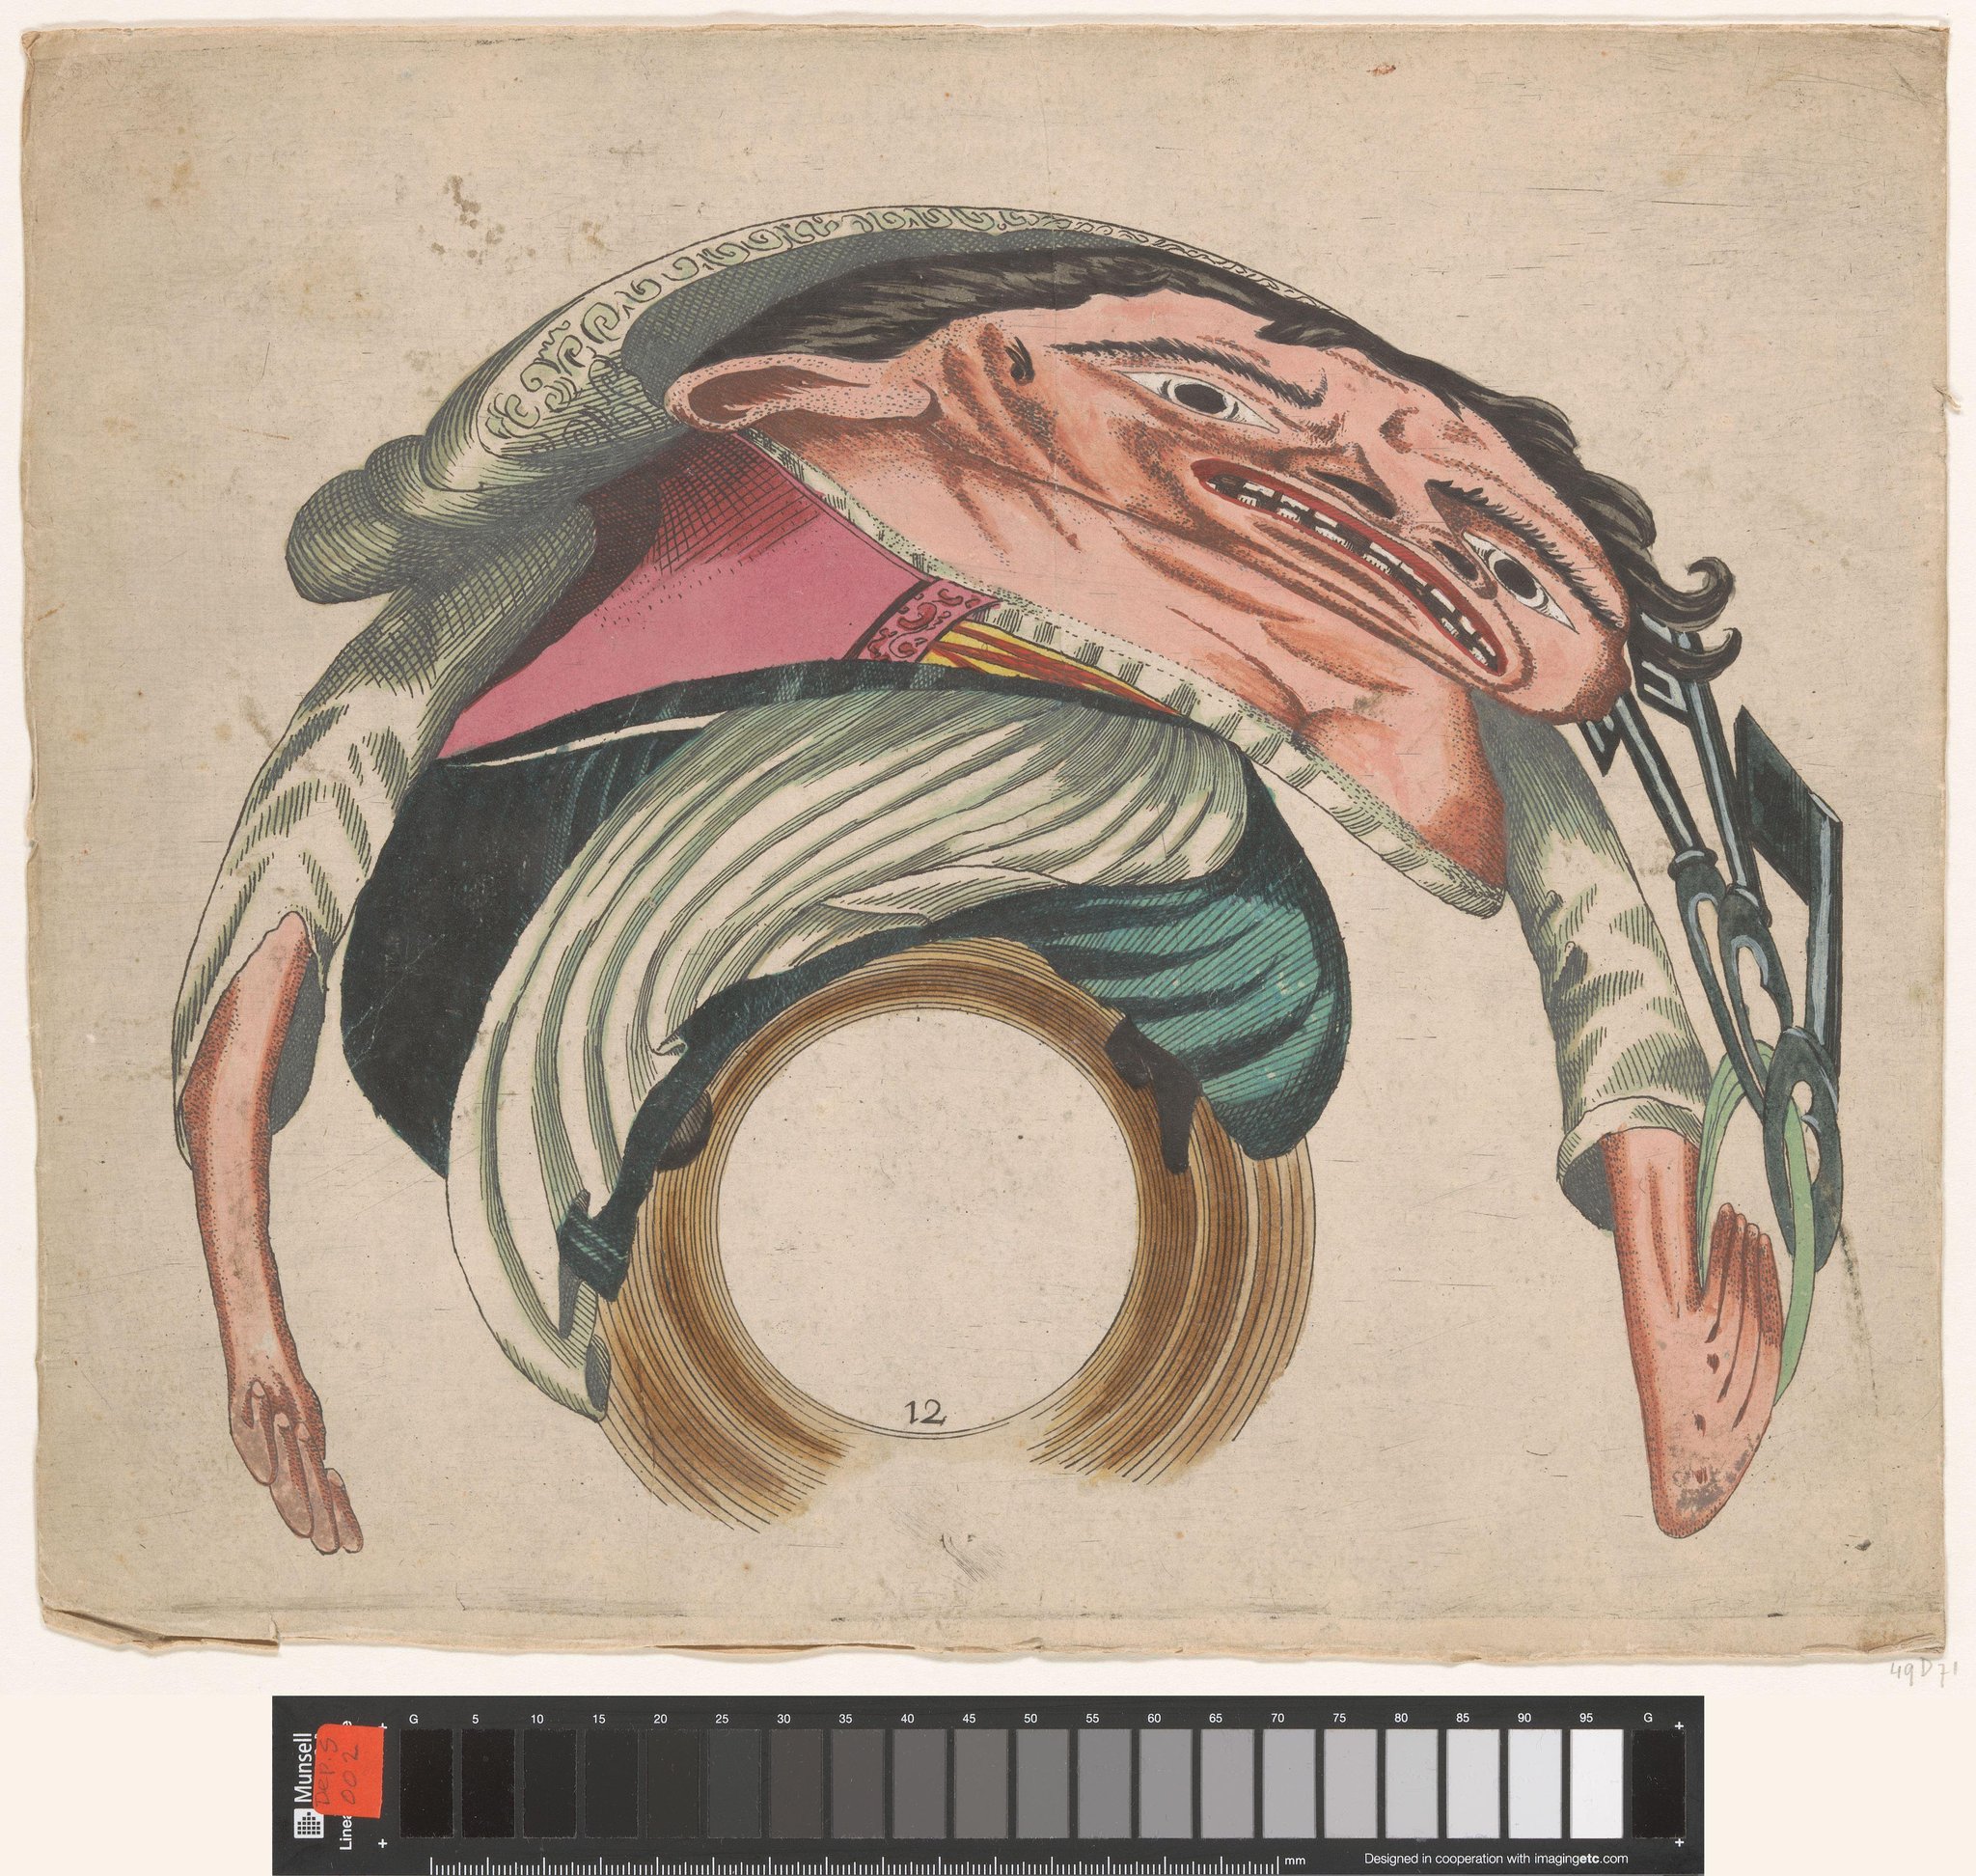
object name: print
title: Anamorfose van een vrouw met sleutelbos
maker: Anonymous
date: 1700-1850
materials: paper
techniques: etching, hand coloring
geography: germany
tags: anamorphosis, key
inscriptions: collector's mark: Lugt 2028